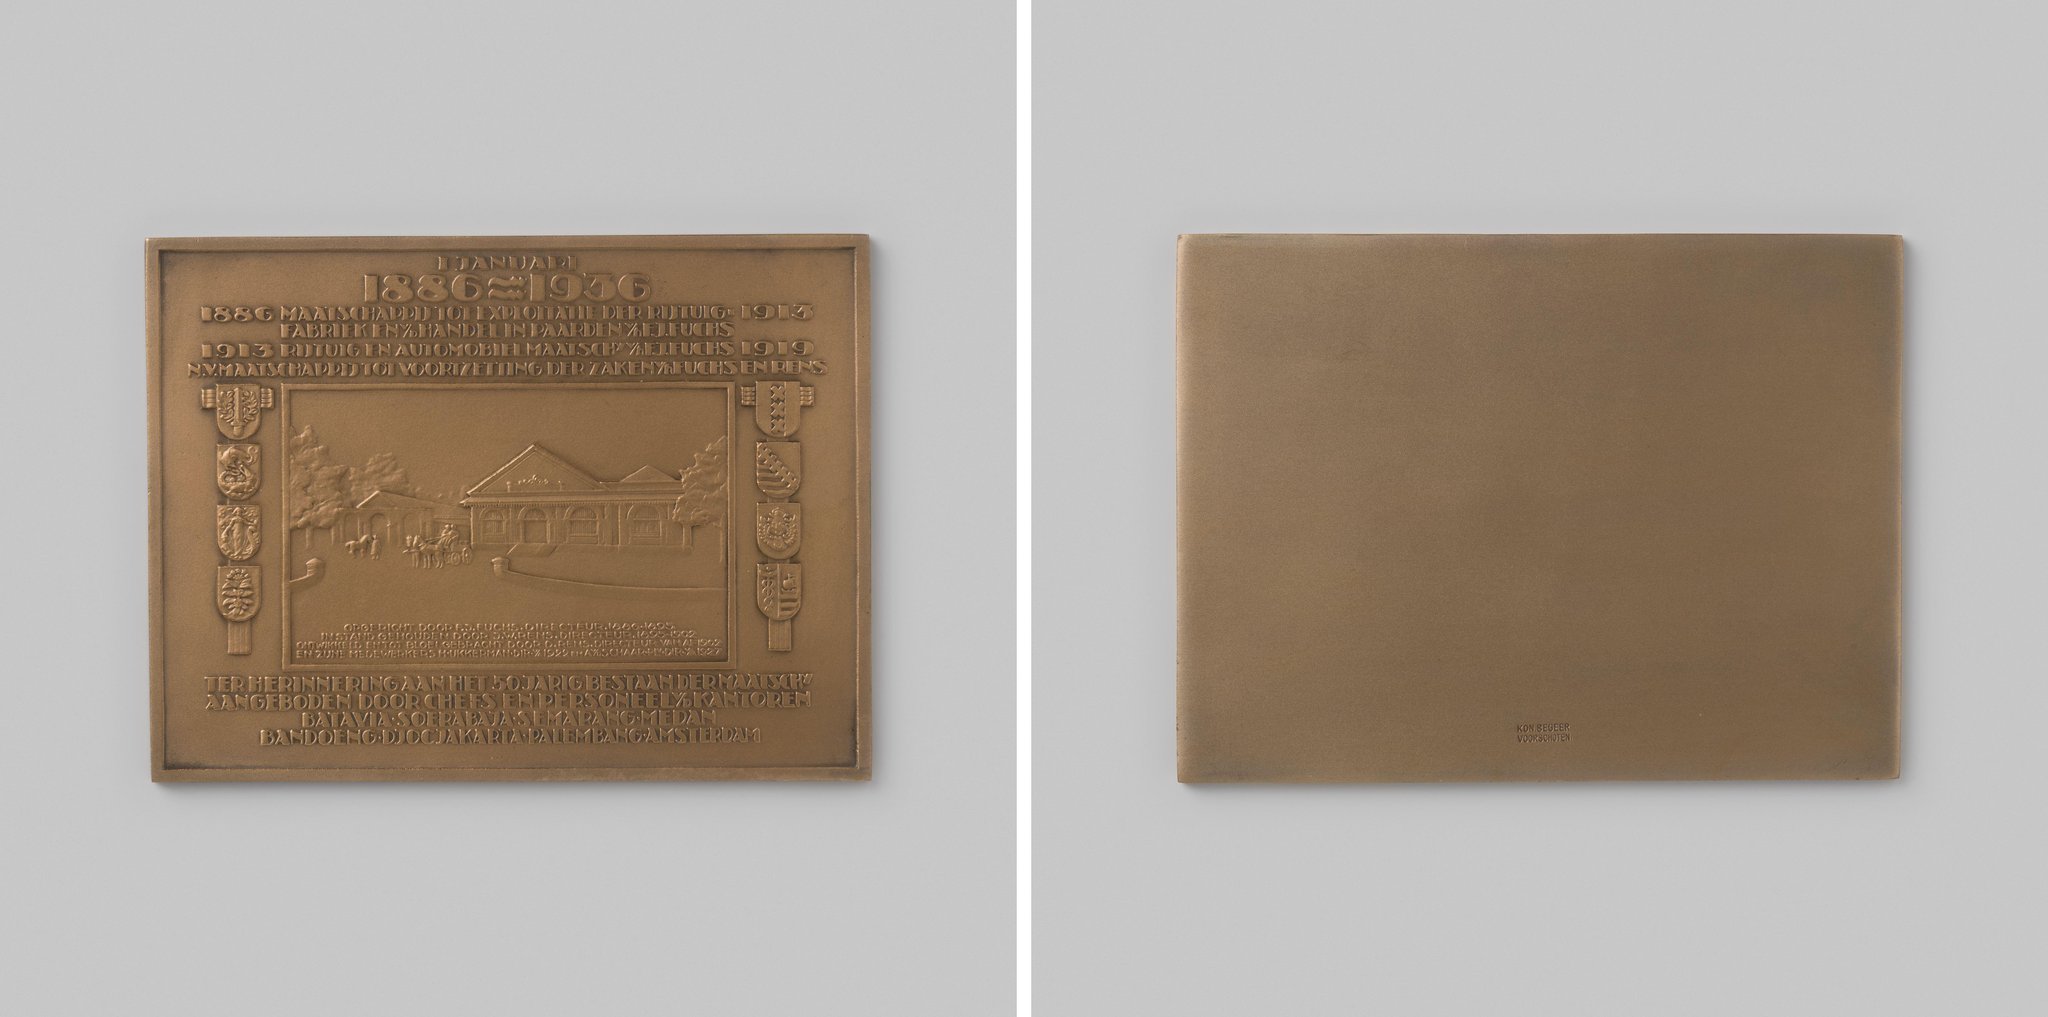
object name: plaque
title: Plaquette ter gelegenheid van het 50-jarig bestaan van de Nederlands-Indische Maatschappij in rijtuigen en automobielen v/h F.J. Fuchs en Rens, 1886 - 1936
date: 1936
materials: bronze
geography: voorschoten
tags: voorschoten, dutch east indies, the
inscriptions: mark: ‘KON. BEGEER / VOORSCHOTEN’, inscription: ‘1 JANUARI / 1886=1936 / 1886 MAATSCHAPPIJ TOT EXPLOITATIE DER RIJTUIG- 1913 / FABRIEK EN V/D HANDEL IN PAARDEN V/H F.J. FUCHS / 1913 RIJTUIG EN AUTOMOBIELMAATSCHY V/H F.J. FUCHS 1919 / N.V. MAATSCHAPPIJ TOT VOORTZETTING DER ZAKEN V/H FUCHS EN RENS’, inscription: ‘TER HERINNERING AAN HET 50JARIG BESTAAN DER MAATSCHY / AANGEBODEN DOOR CHEFS EN PERSONEEL v/d KANTOREN / BATAVIA.SOERABAJA.SEMARANG.MEDAN / BANDOENG.DJOCJAKARTA.PALEMBANG.AMSTERDAM’, inscription: ‘OPGERICHT DOOR F.J. FUCHS.DIRECTEUR.1886-1895 / IN STAND GEHOUDEN DOOR J.W.RENS.DIRECTEUR.1895-1902 / ONTWIKKELD EN TOT BLOEI GEBRACHT DOOR D.RENS.DIRECTEUR VANAF 1902 / EN ZIJNE MEDEWERKERS H.UKKERMAN.DIR.V/A1922 EN AV/DSCHAAR.PLV.DIR.V/A1927’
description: Rechthoekige gedenkplaquette met m.b. datering en tekst; daaronder in kader: afbeelding van de fabriek met de namen en data van de verschillende directeuren van de onderneming. Links en rechta van het kader: tweemaal 4 stadswapens. Onder het kader eveneens tekst. Op keerzijde: naam en plaats vervaardiger.